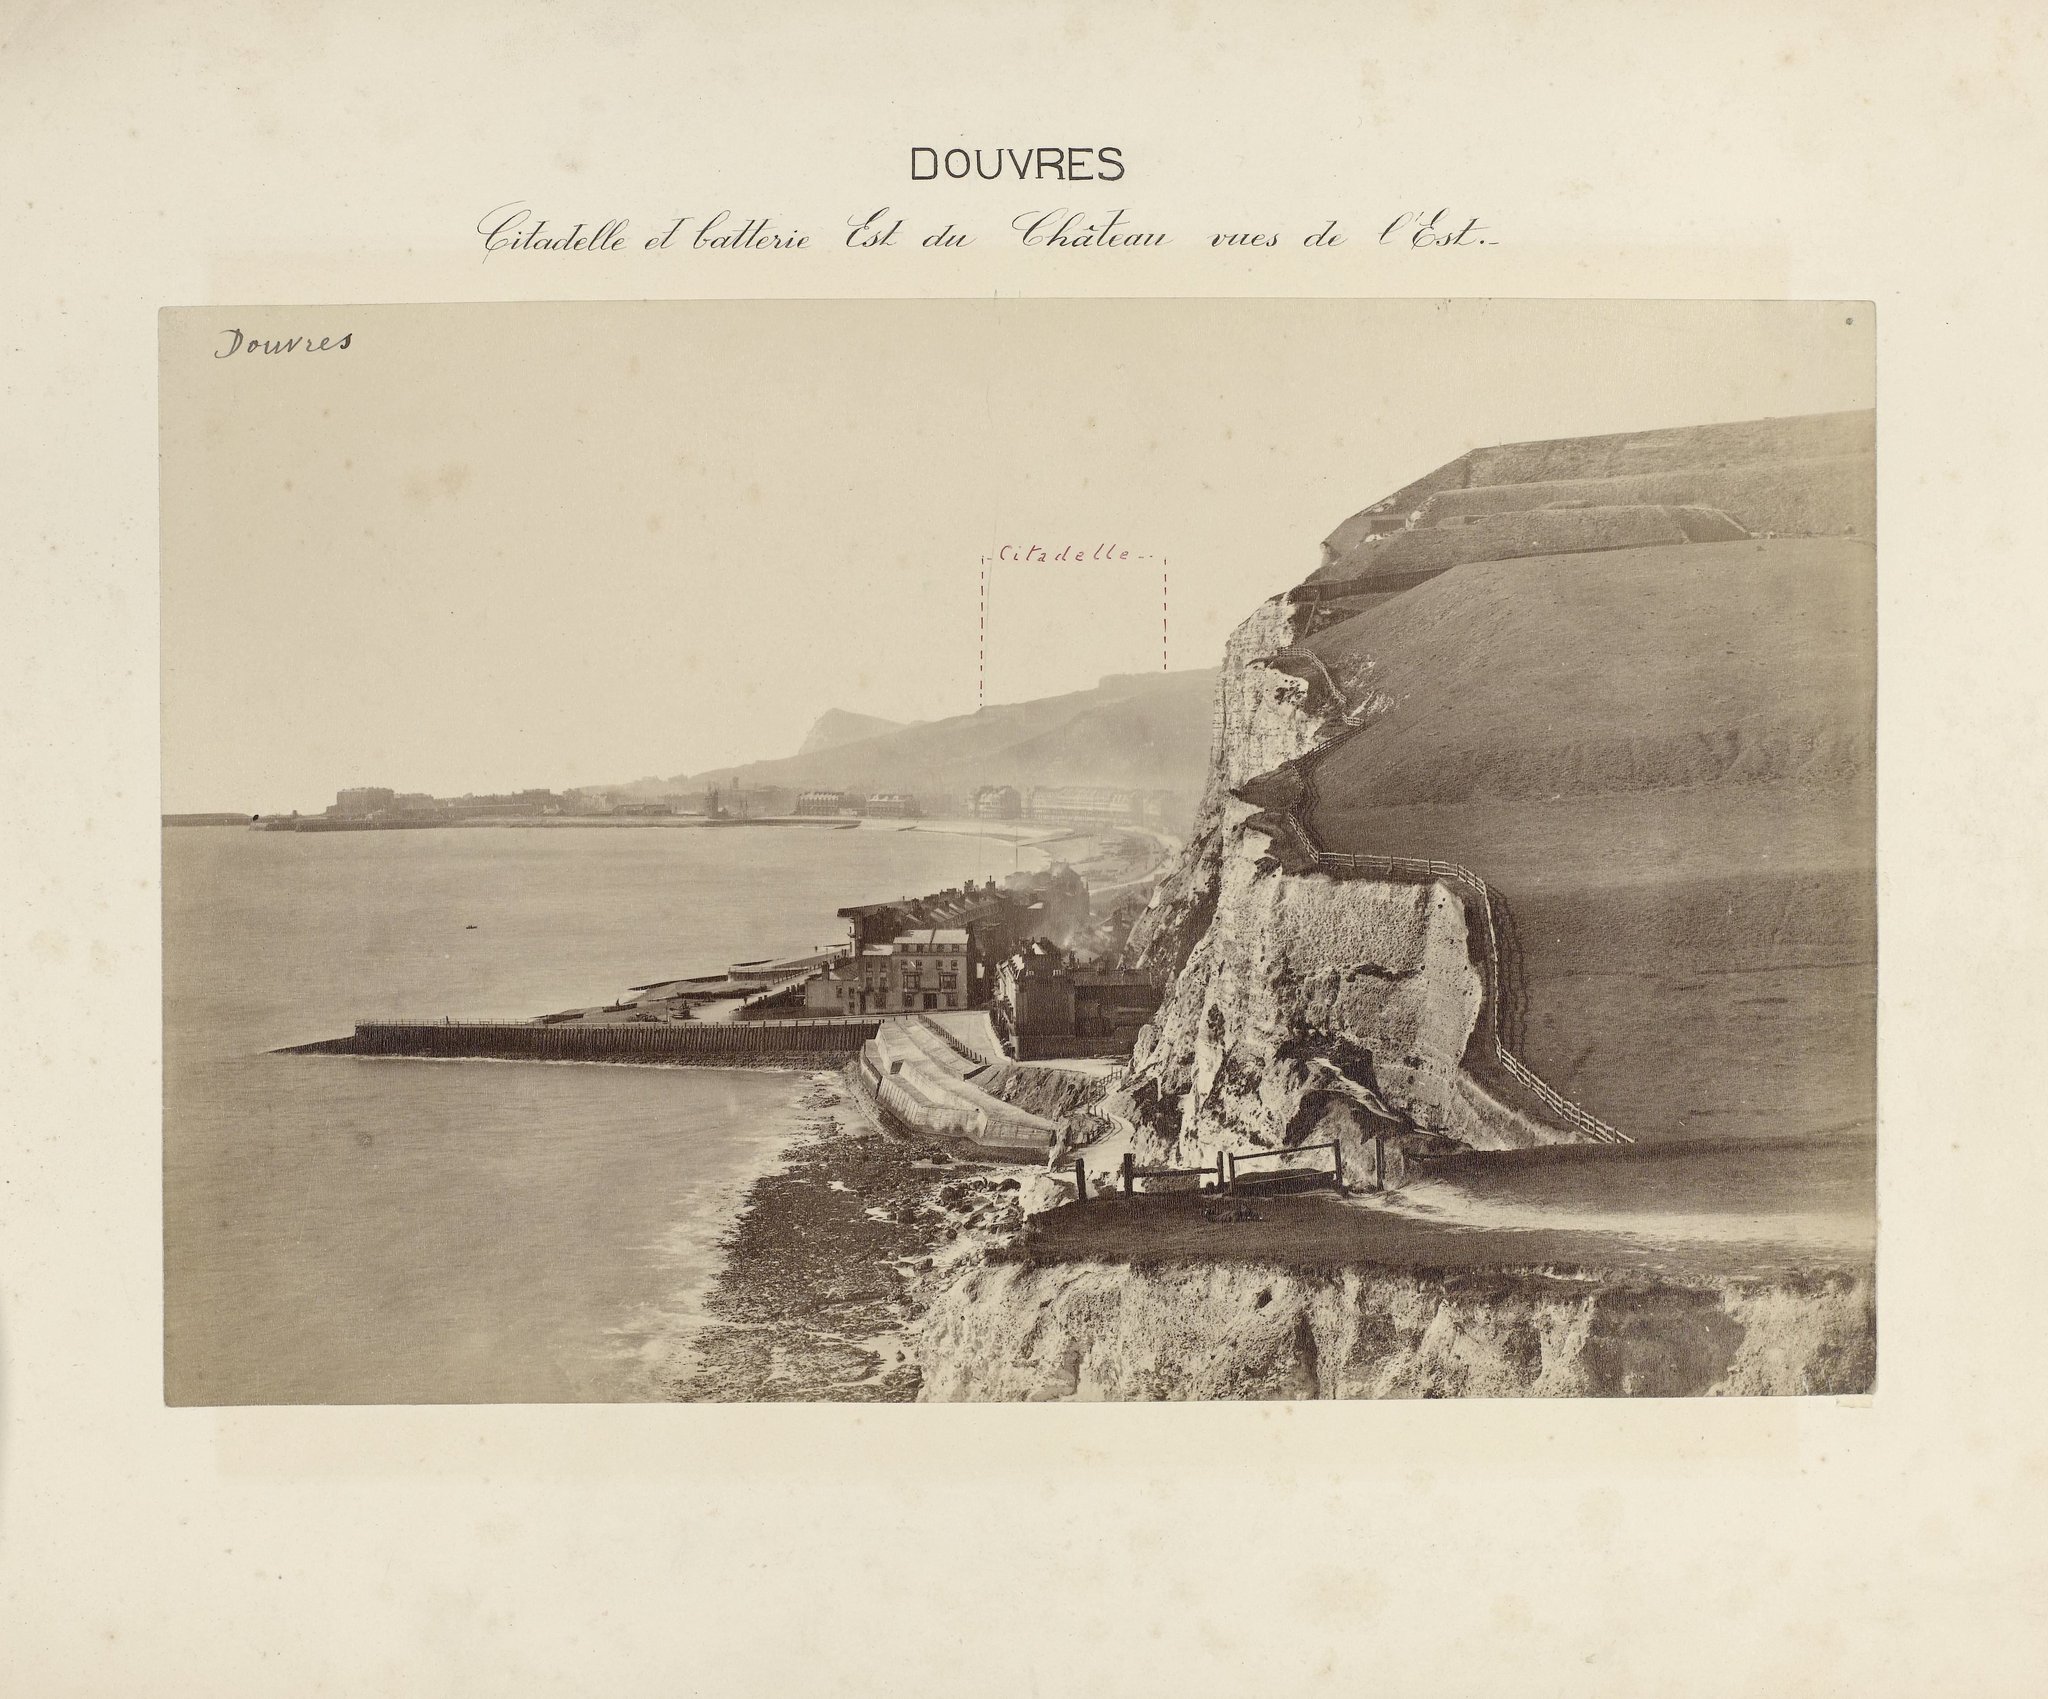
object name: photograph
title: Gezicht op Dover en de krijtrotsen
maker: Anonymous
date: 1891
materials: cardboard, paper, photographic support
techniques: albumen print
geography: great britain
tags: dover (engeland)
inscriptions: inscription: ‘Douvres’, inscription: ‘DOUVRES / Citadelle et batterie Est du Château vues de l'Est’, annotation: ‘Citadelle’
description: Foto uit een album met 35 topografische foto's van Britse kustplaatsen, waarop in pen militaire verdedigingswerken zijn aangegeven door een Franse militair.